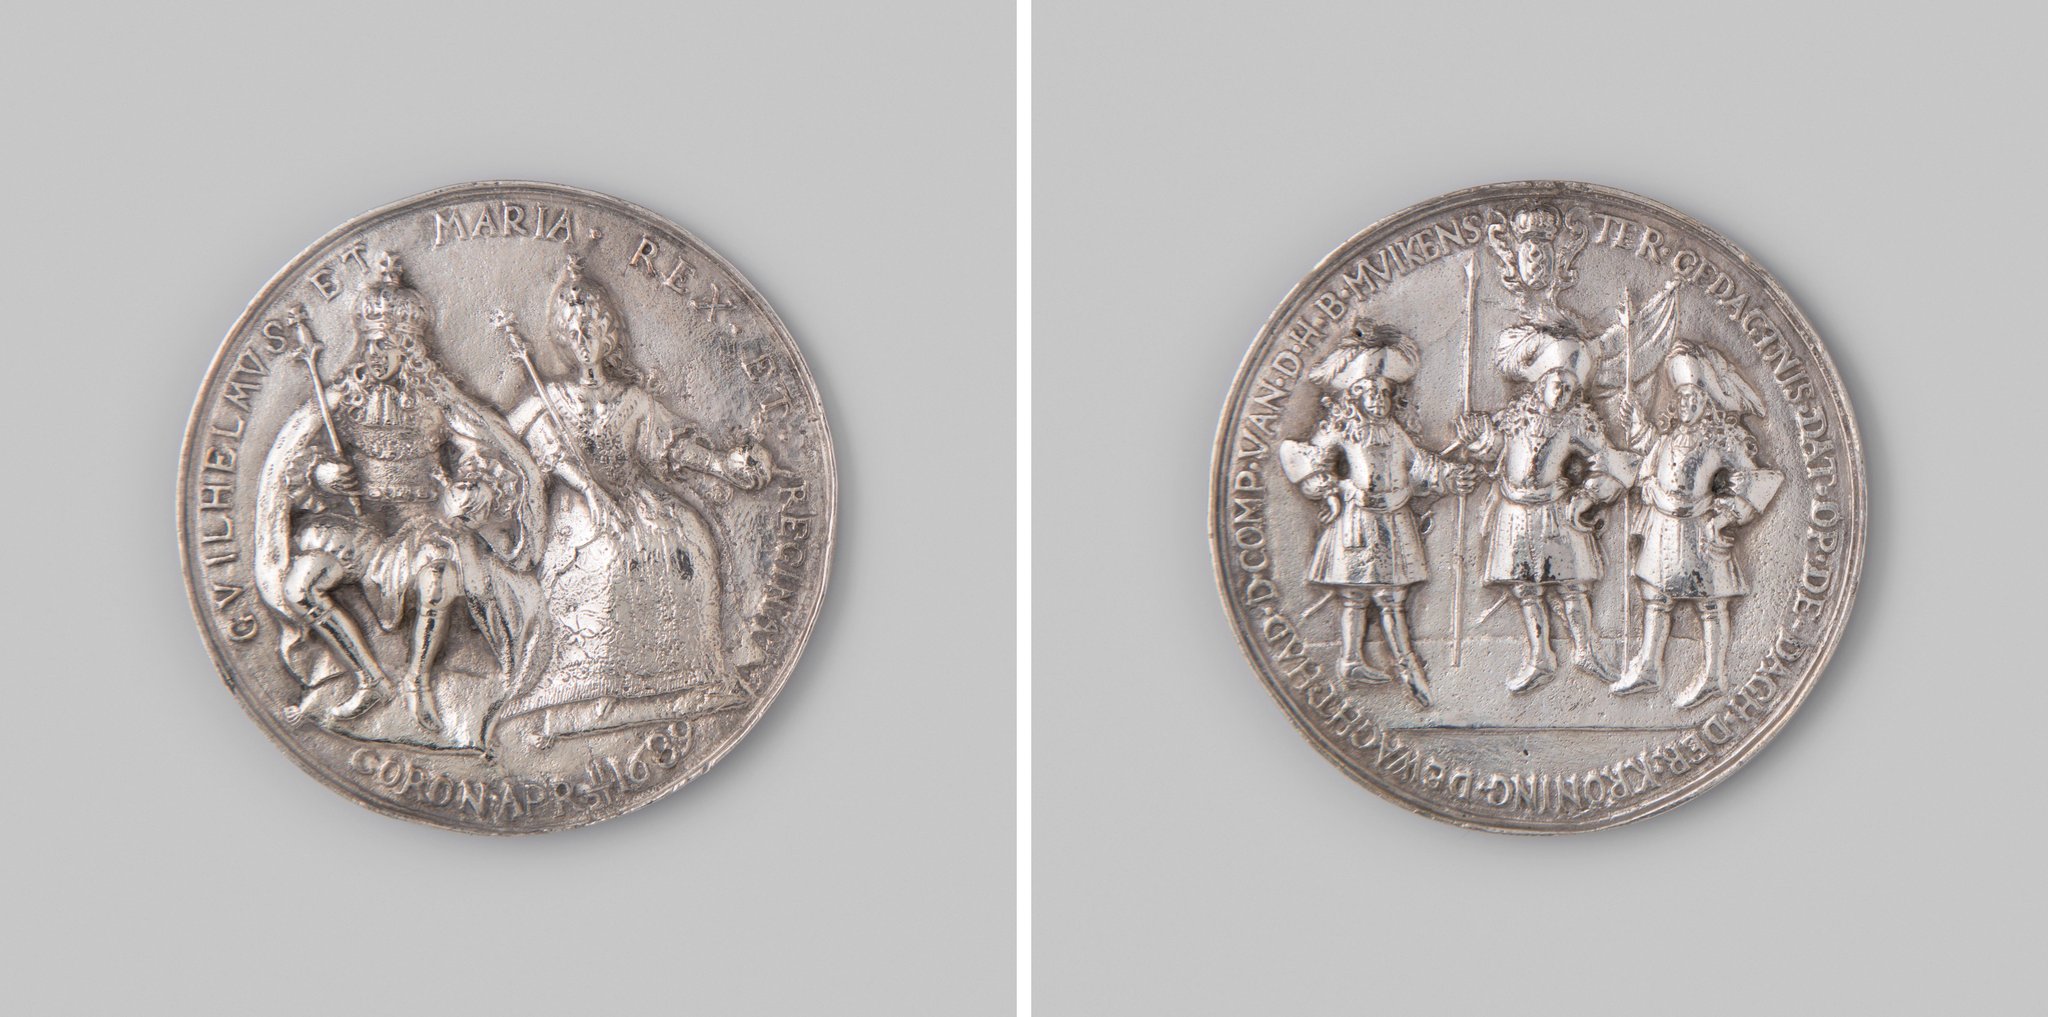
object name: history medal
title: Viering van de kroning van Willem III en Maria te Amsterdam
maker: Anonymous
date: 1689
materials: silver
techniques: casting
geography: amsterdam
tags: the hague, william iii (prince of orange and king of england, scotland, and ireland), maria ii stuart (koningin van engeland, schotland en ierland), amsterdam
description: Zilveren penning. Voorzijde: Willem en Maria gezeten op troon met kroon, scepter en rijksappel binnen omschrift. Keerzijde: drie staande schutters met speren en vaandel binnen omschrift